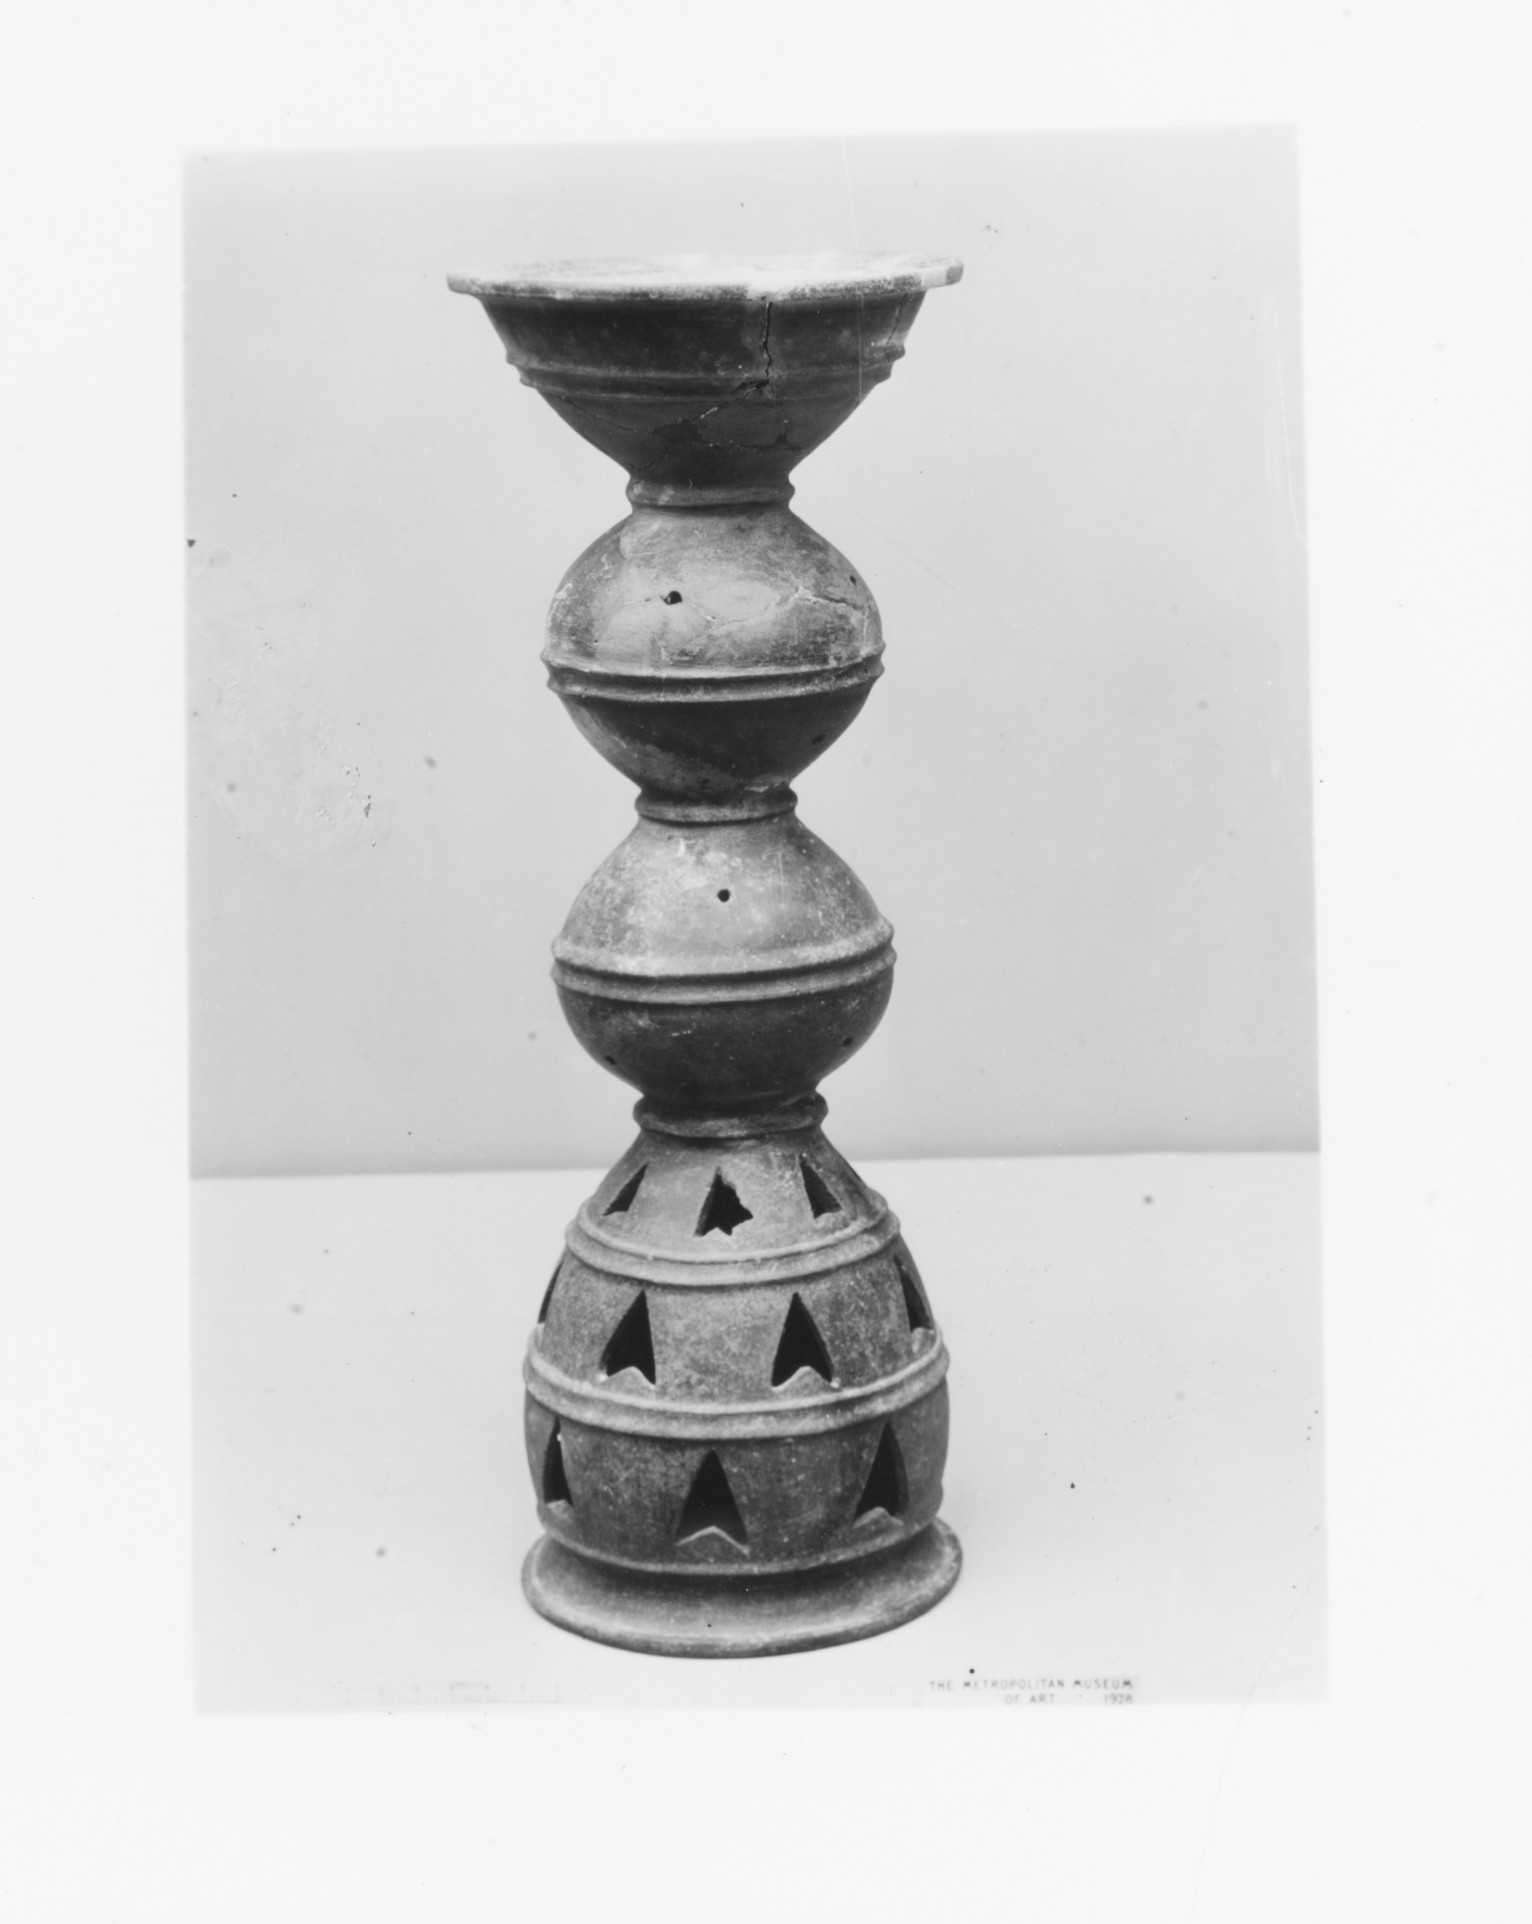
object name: stand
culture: etruscan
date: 700-651 BCE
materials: terracotta